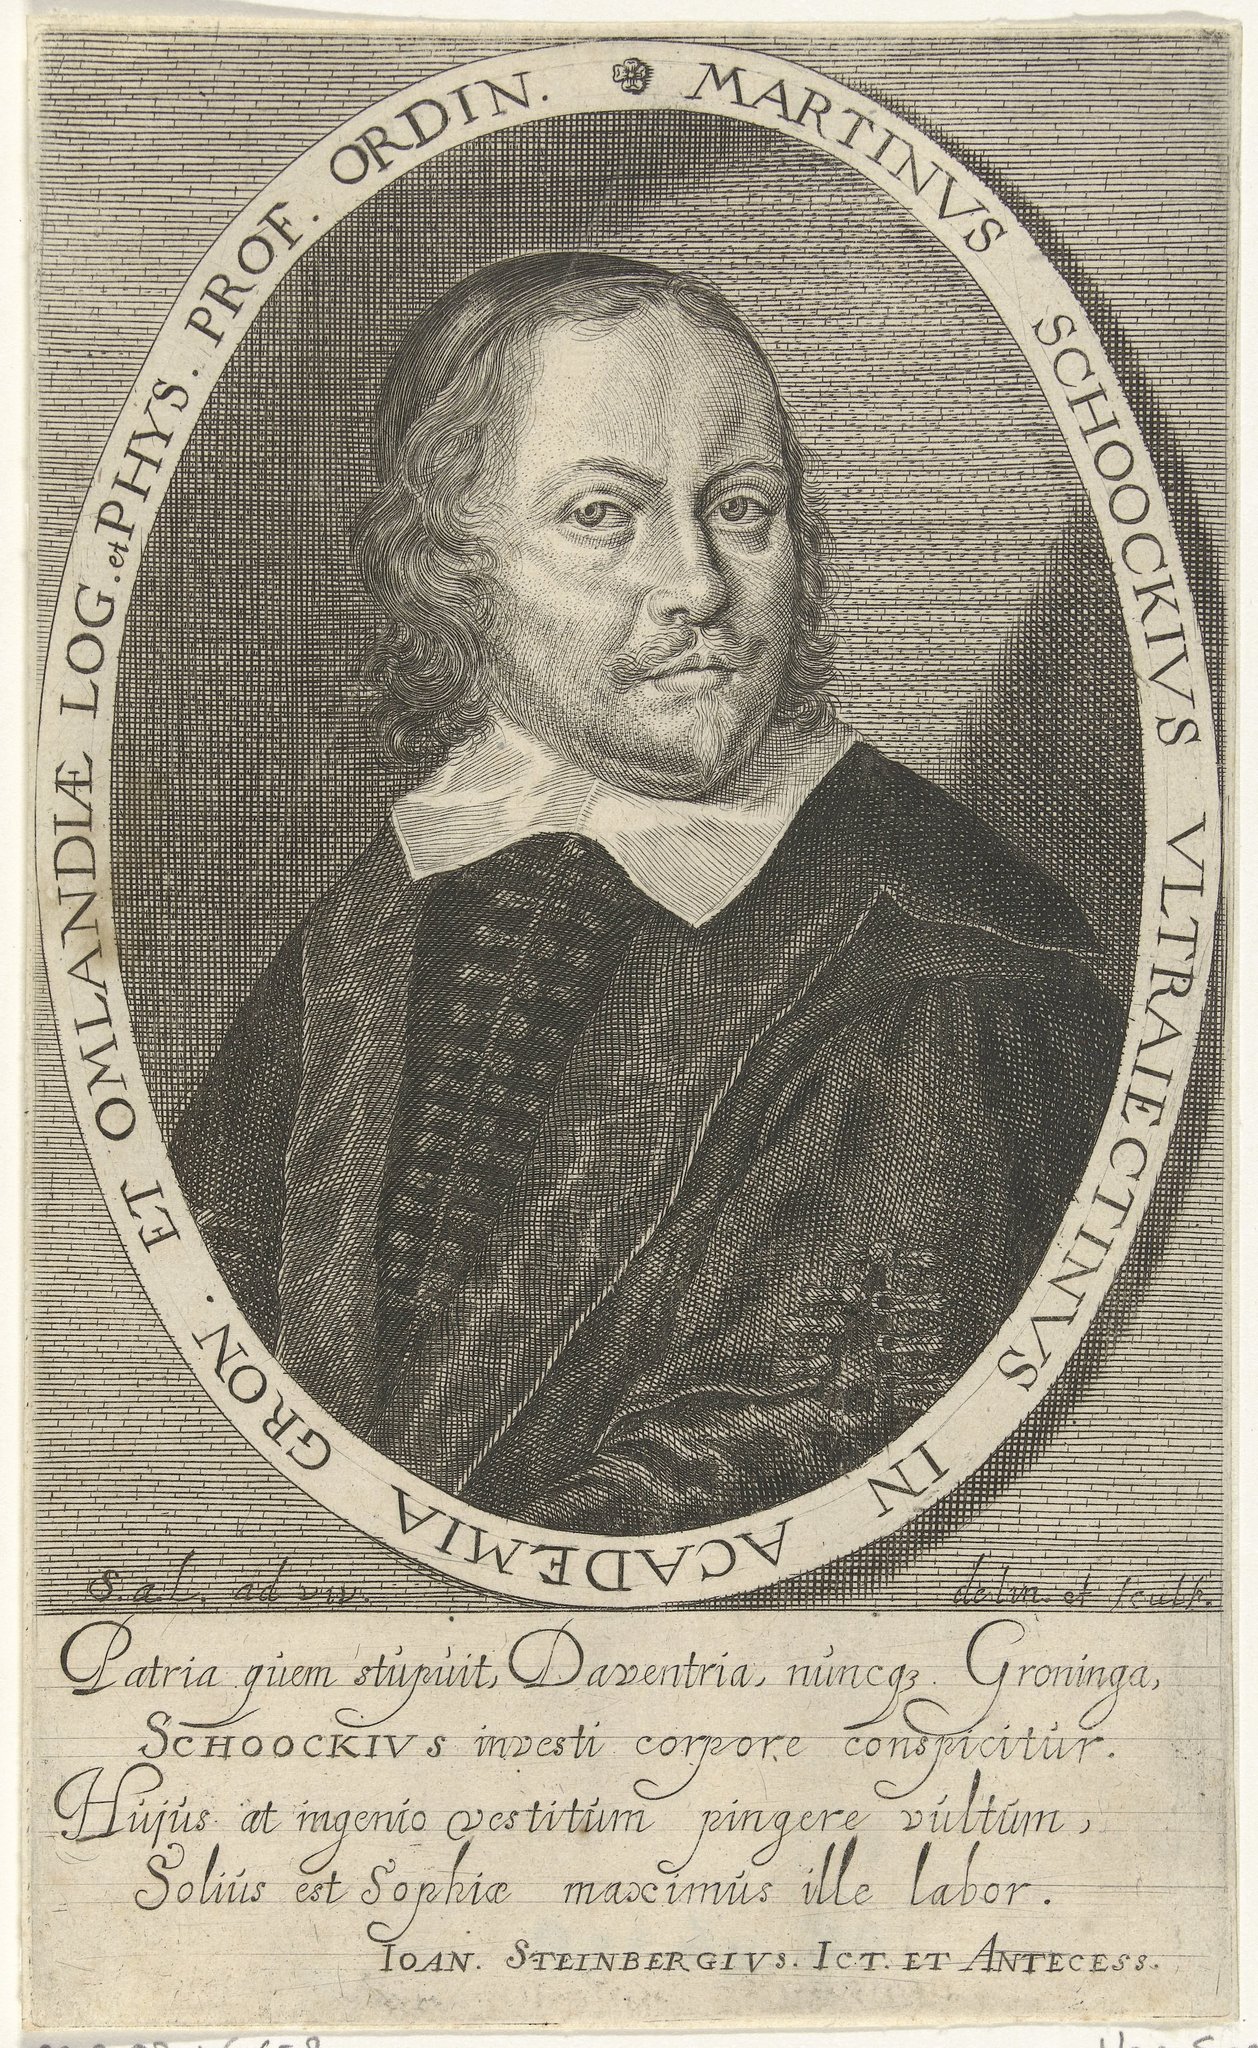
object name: print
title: Portret van Martinus Schoock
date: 1654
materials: paper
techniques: engraving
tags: martinus schoock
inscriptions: collector's mark: Lugt 2228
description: Portretbuste in ovaal naar links van Martinus Schoock, hoogleraar in de logica en physica te Groningen. Het hoofd is getooid met een kalot en naar rechts gedraaid. Op de ovale omlijsting staat een randschrift in Latijn, in de marge een vierregelig Latijns vers.